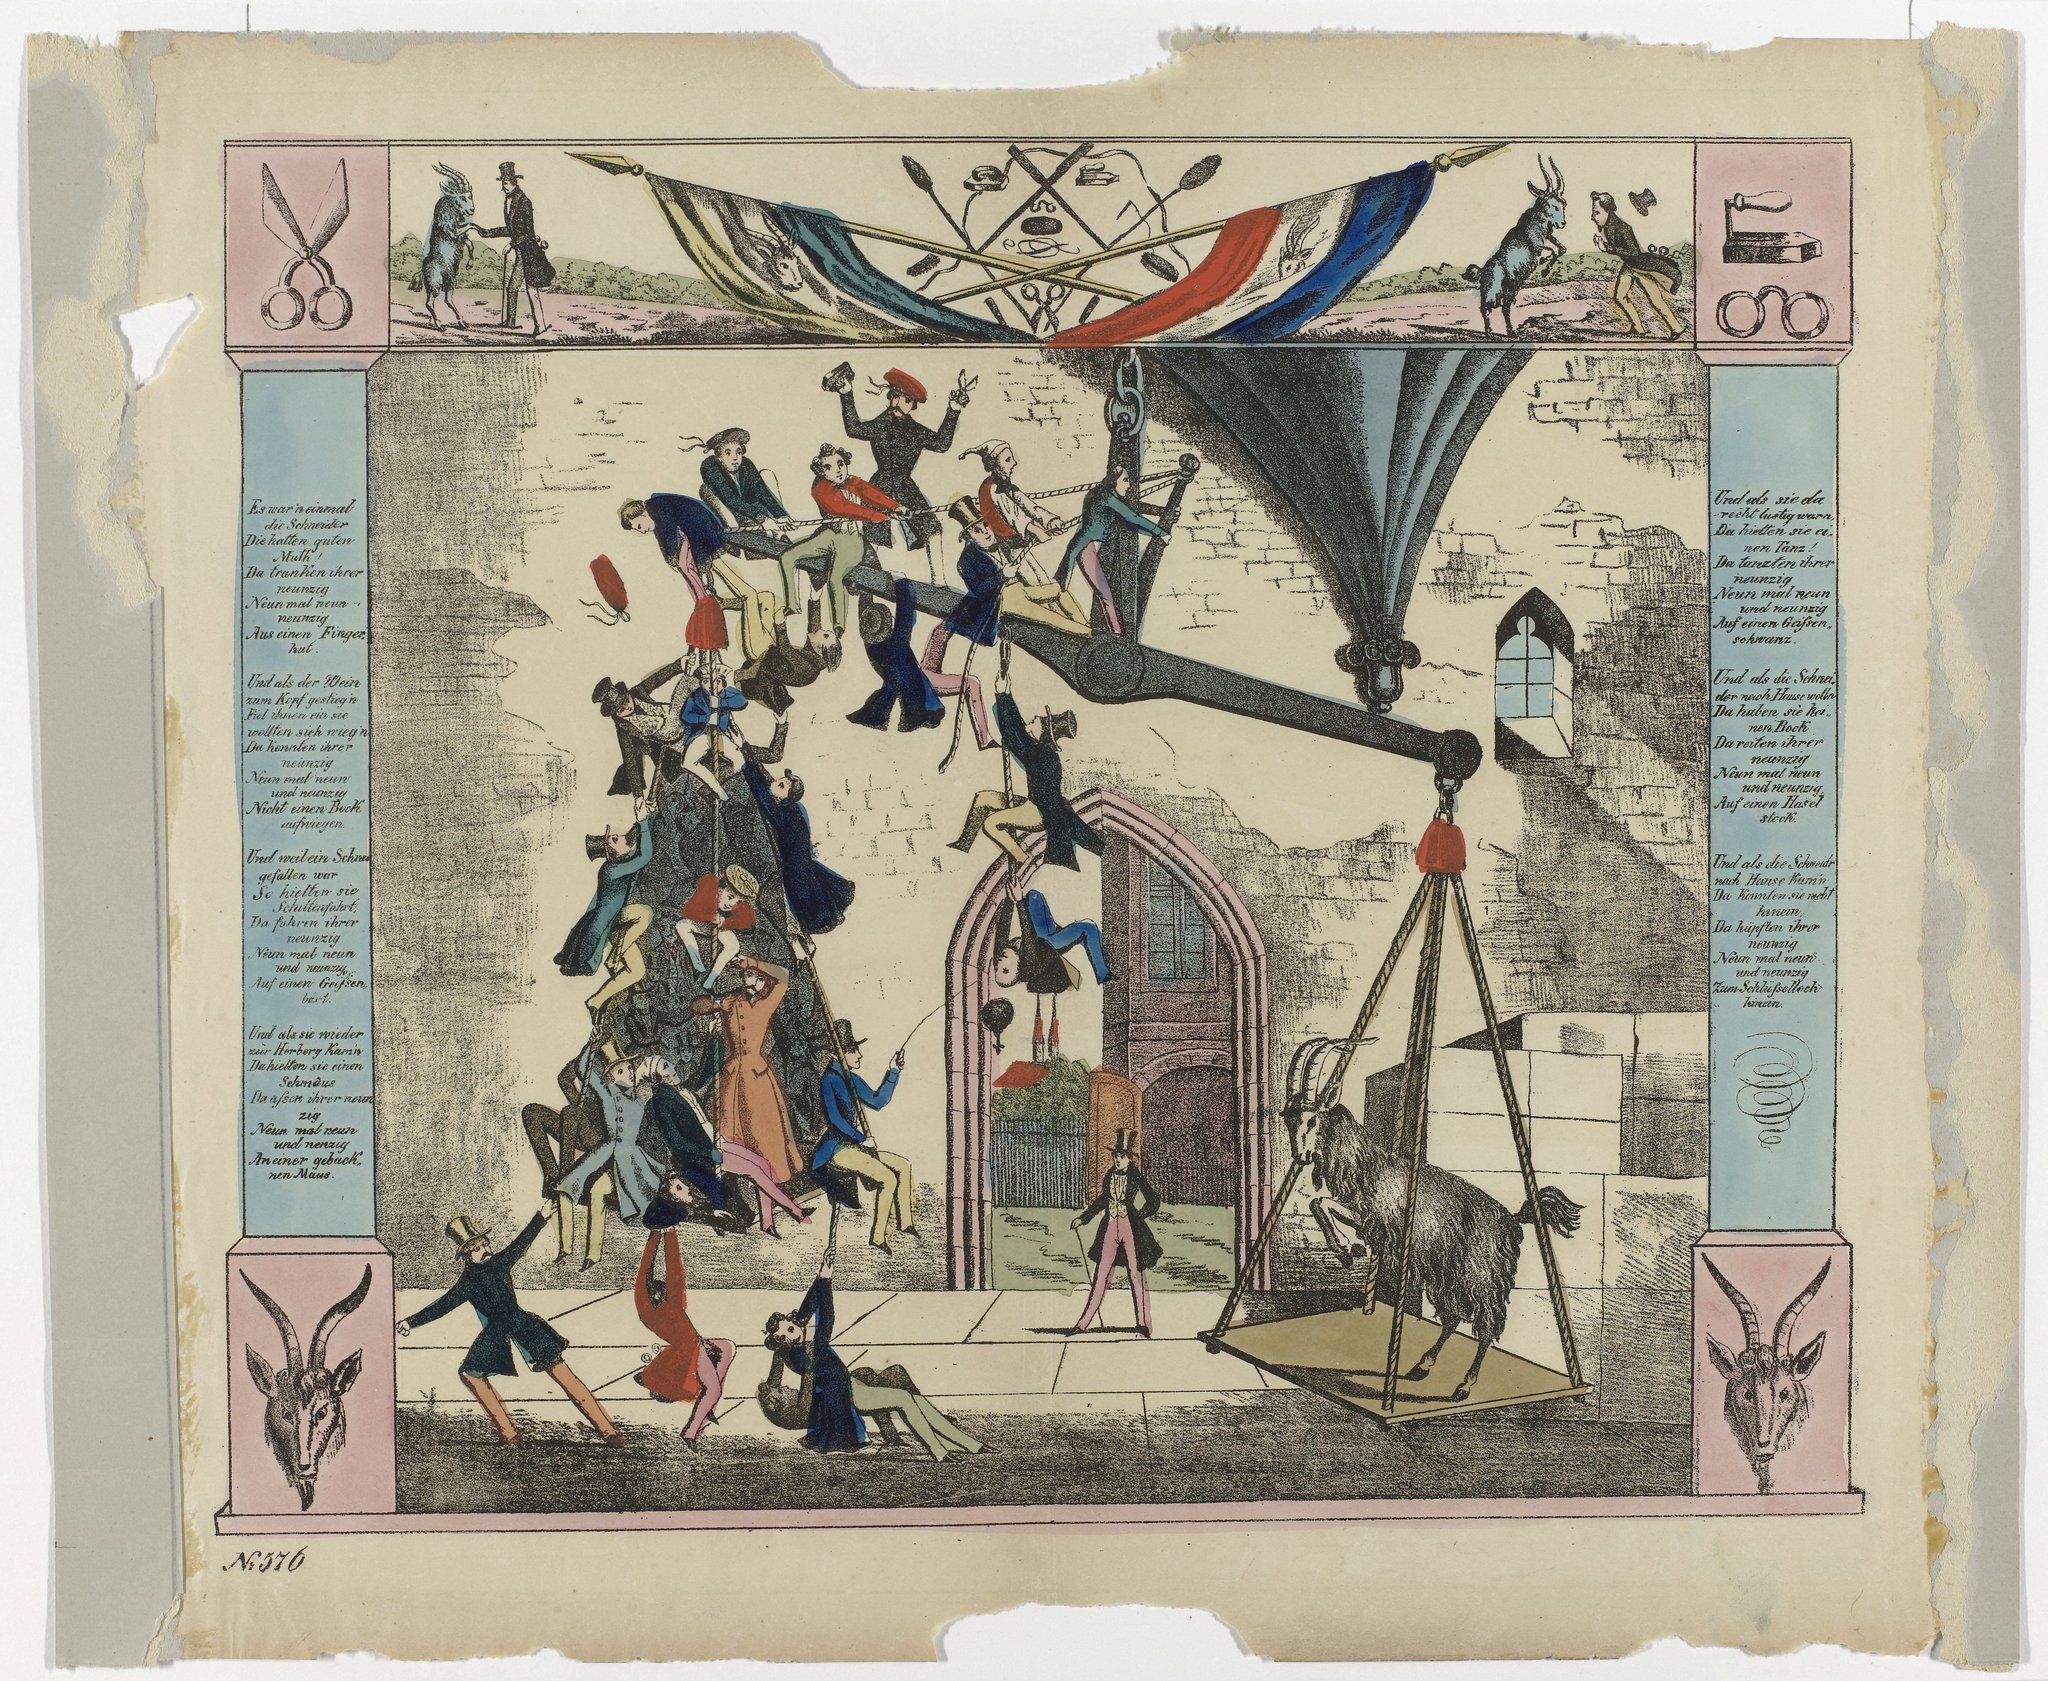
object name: caricature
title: Es war is einmal die schneider, No. 576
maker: Anonymous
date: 1830-1840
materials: paper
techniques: hand coloring, lithograph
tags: scales, he-goat, billy-goat, tailor, dressmaker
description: Weegschaal waarop een bok gewogen wordt tegen een grote groep mannen (kleermakers). Met een lied over de kleermakers die zoetjes aan dronken worden. Ook de bok heeft hier zijn functie.